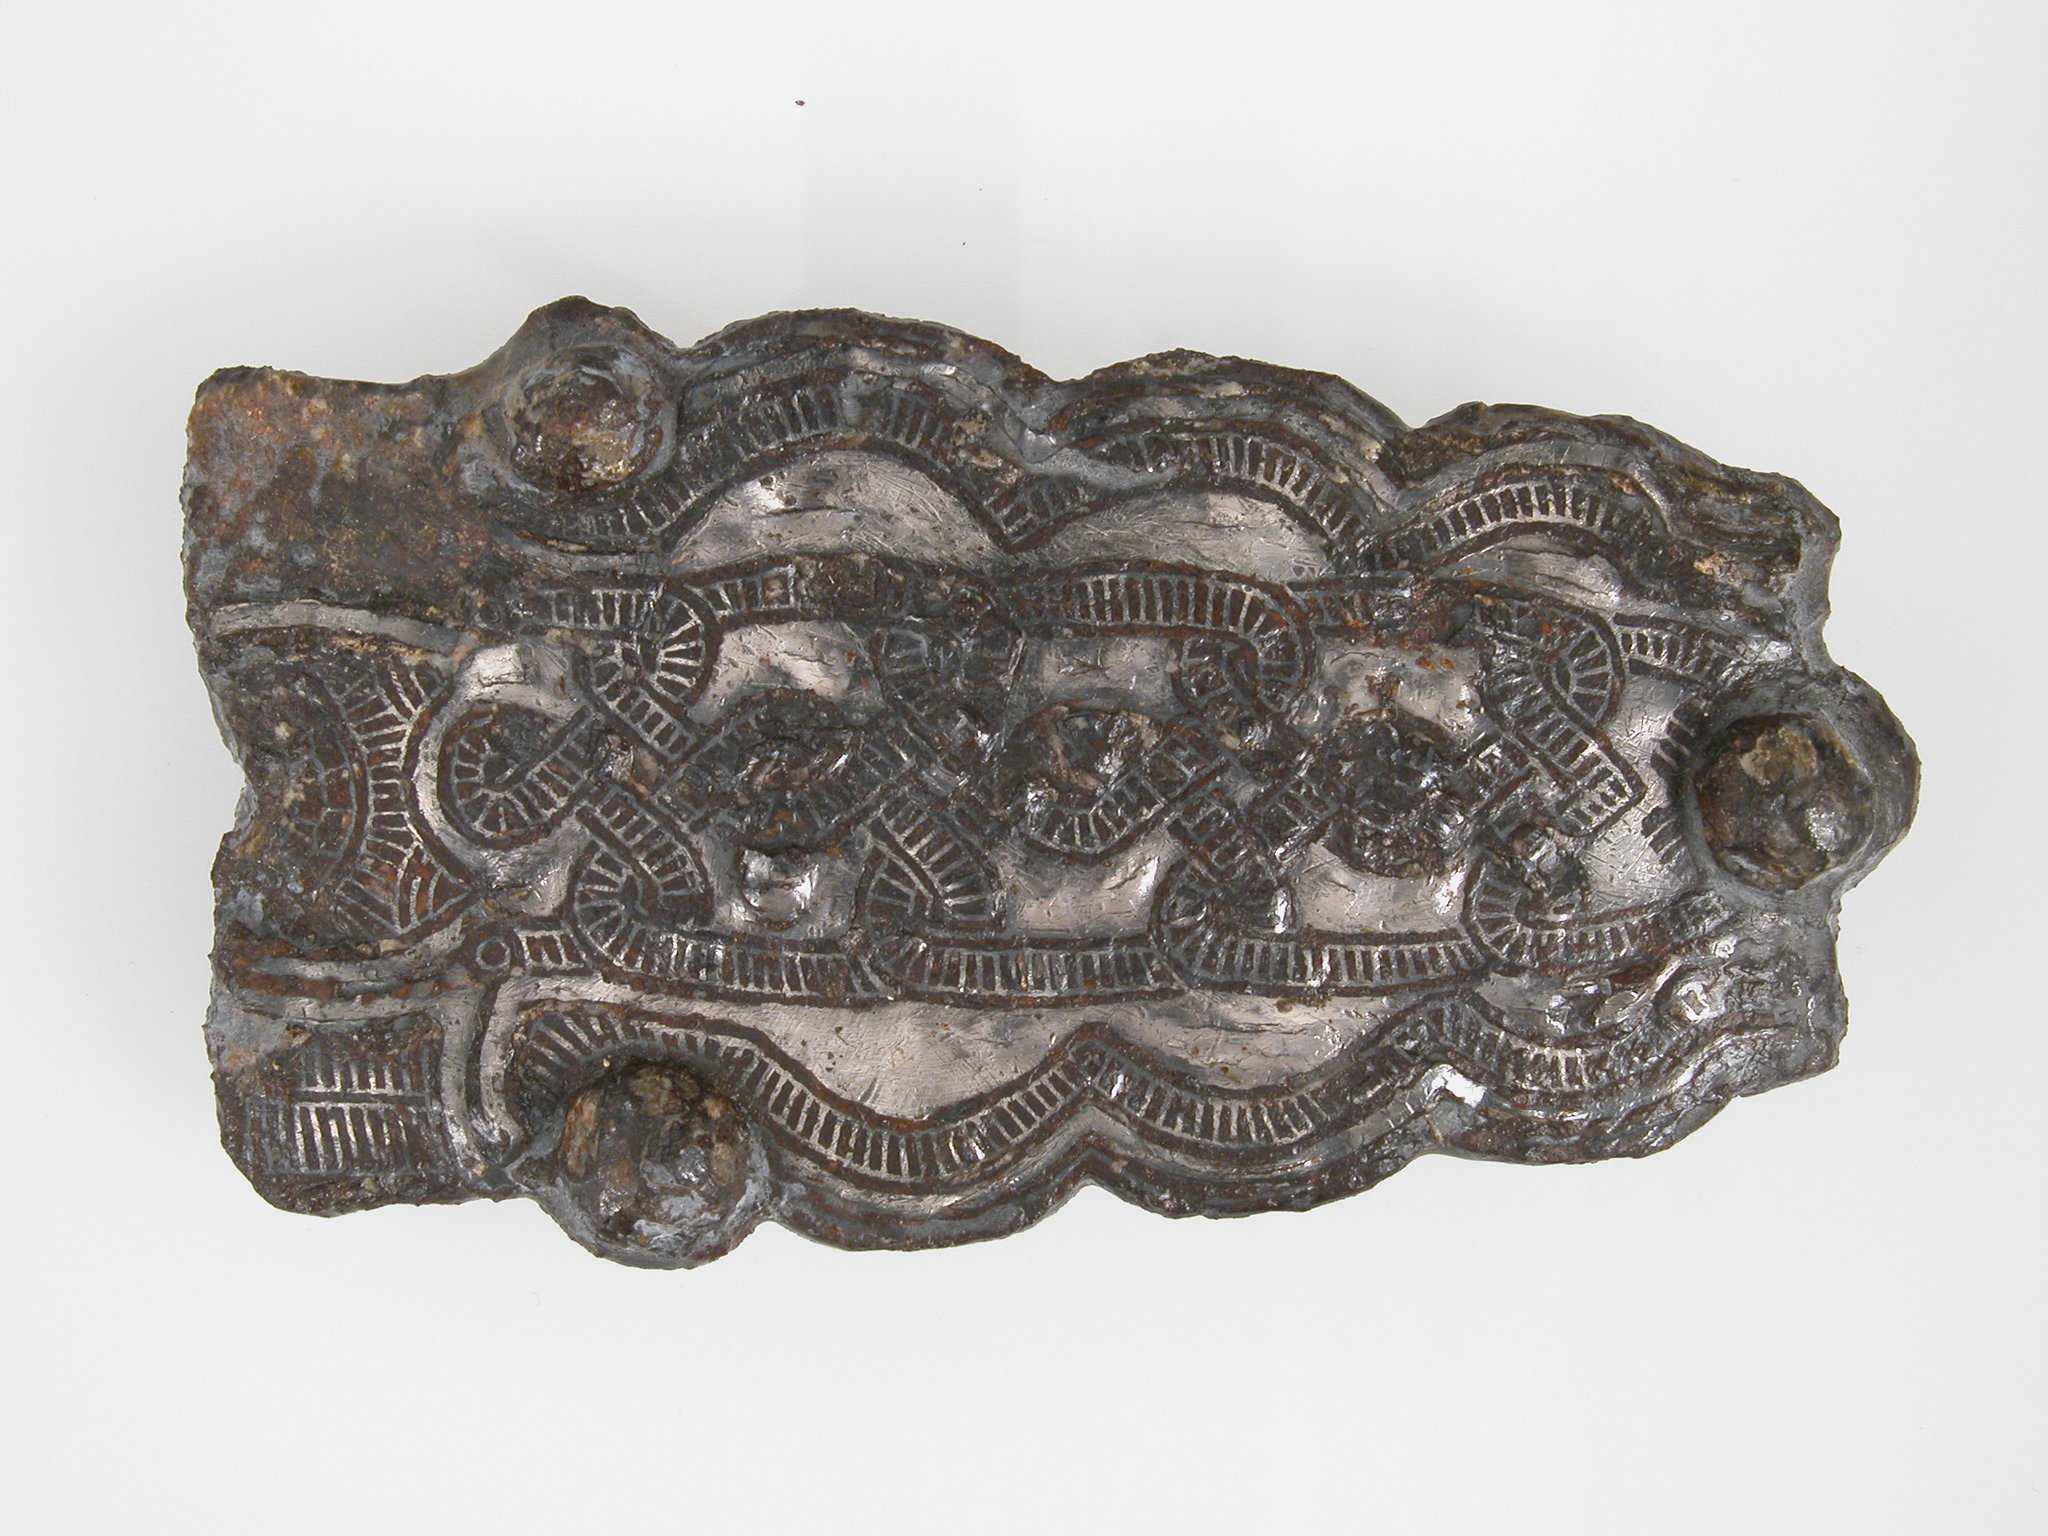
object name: belt plate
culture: frankish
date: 601-700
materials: iron, silver